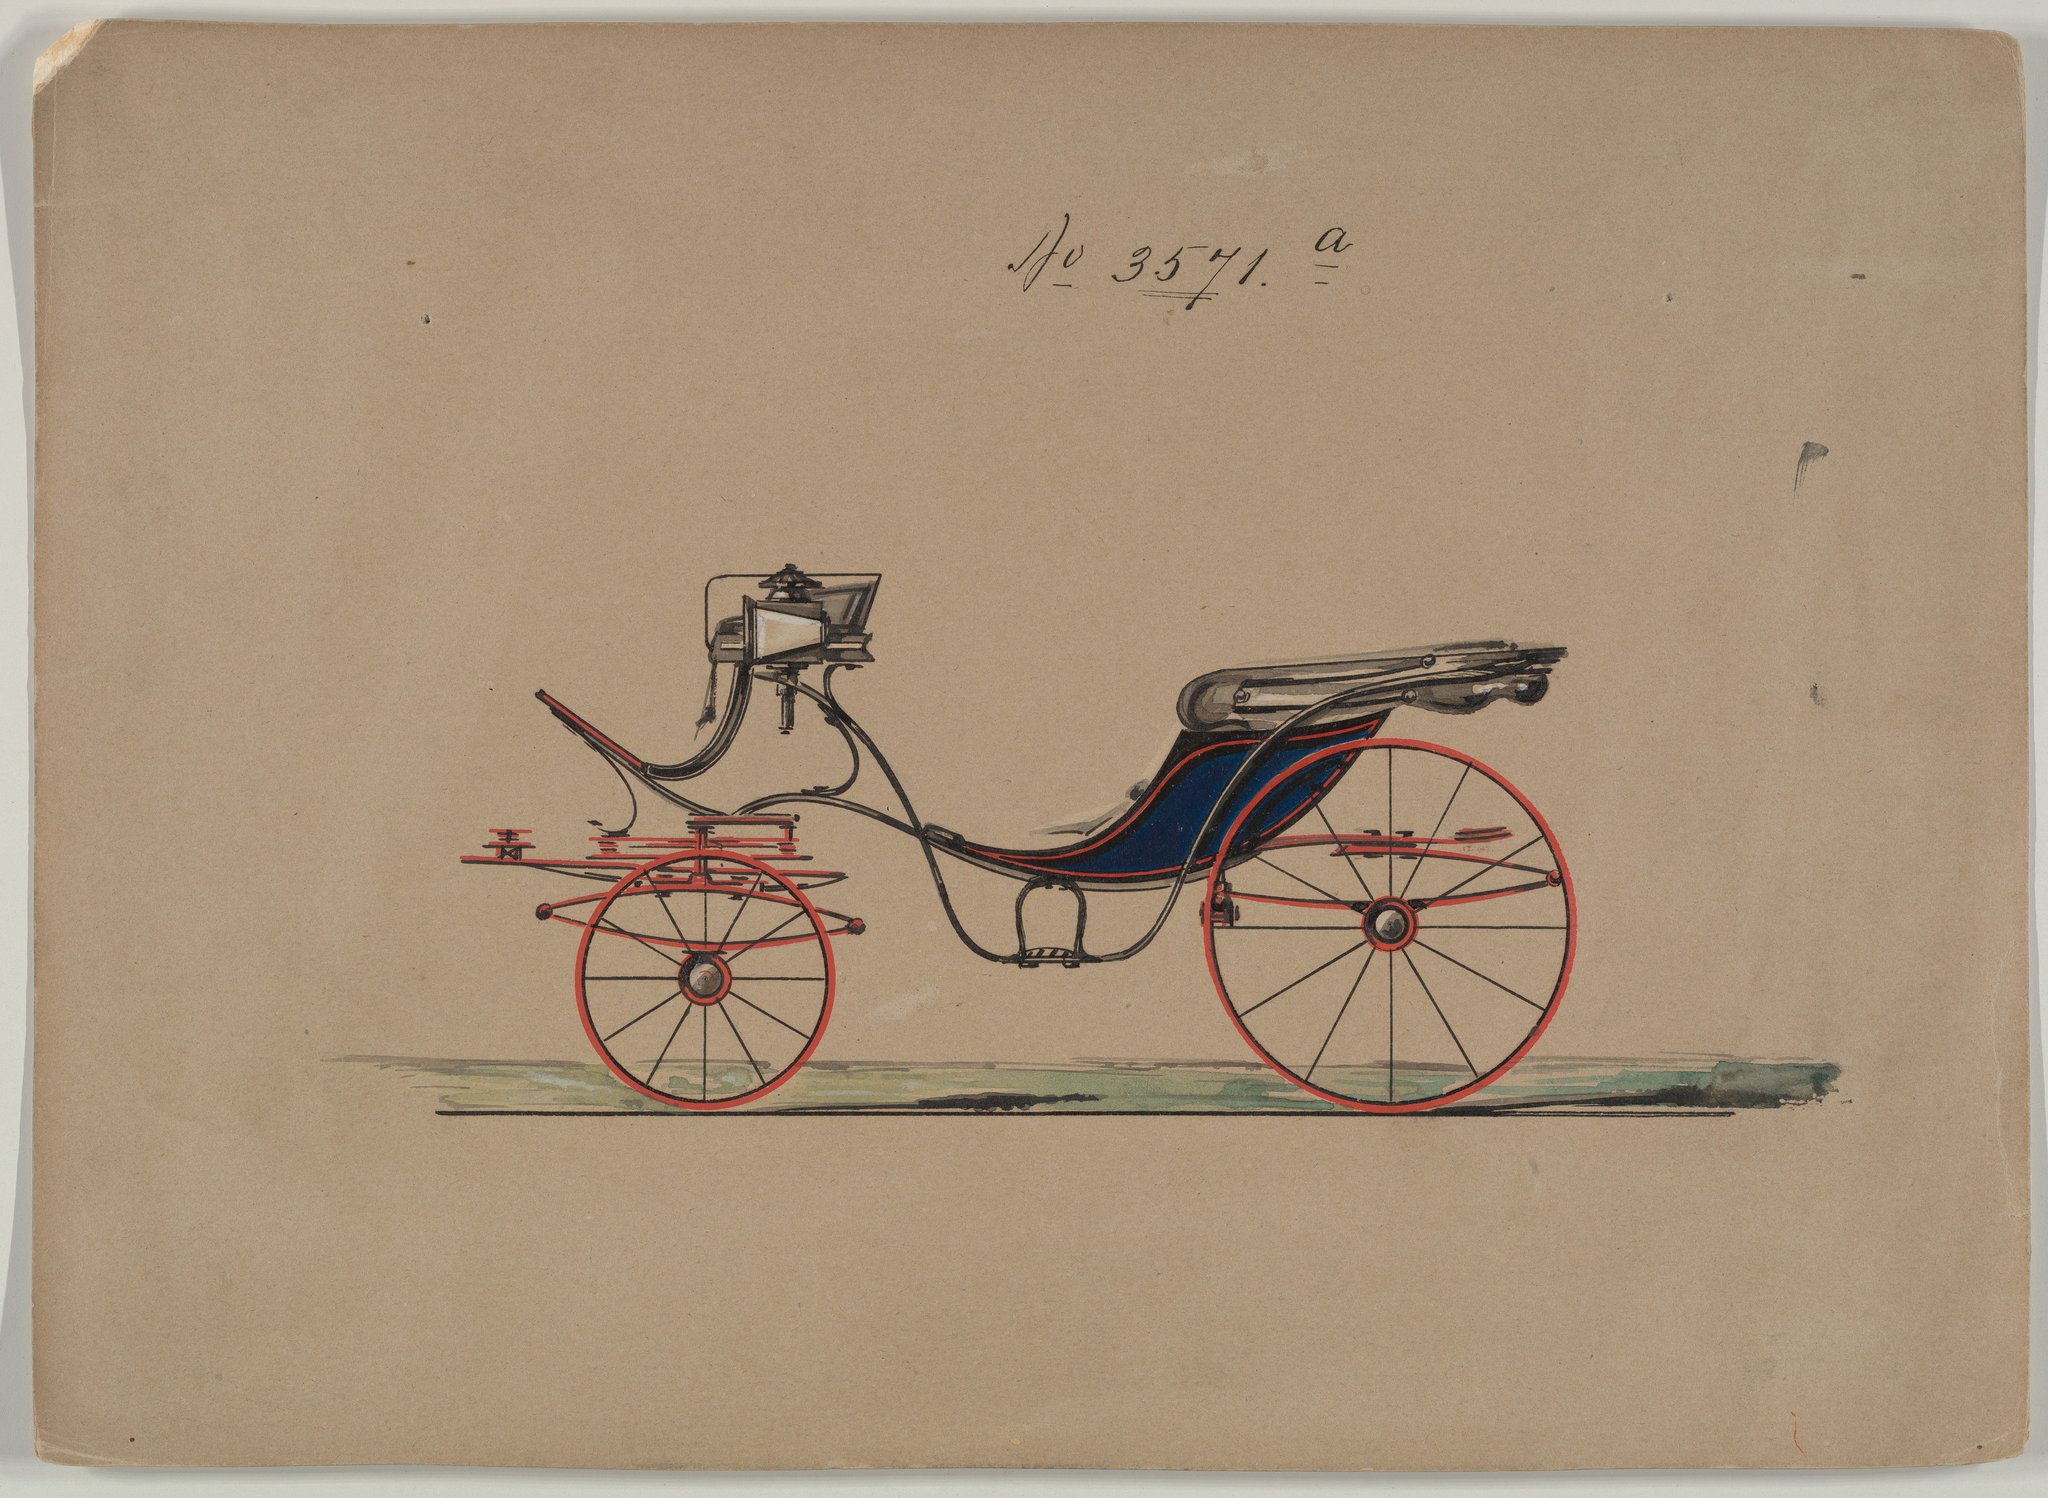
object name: drawing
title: Design for Cabriolet or Victoria, no. 3571a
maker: brewster & co.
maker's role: manufacturer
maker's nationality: american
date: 1880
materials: gouache, gum arabic, ink, watercolor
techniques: pen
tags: carriages